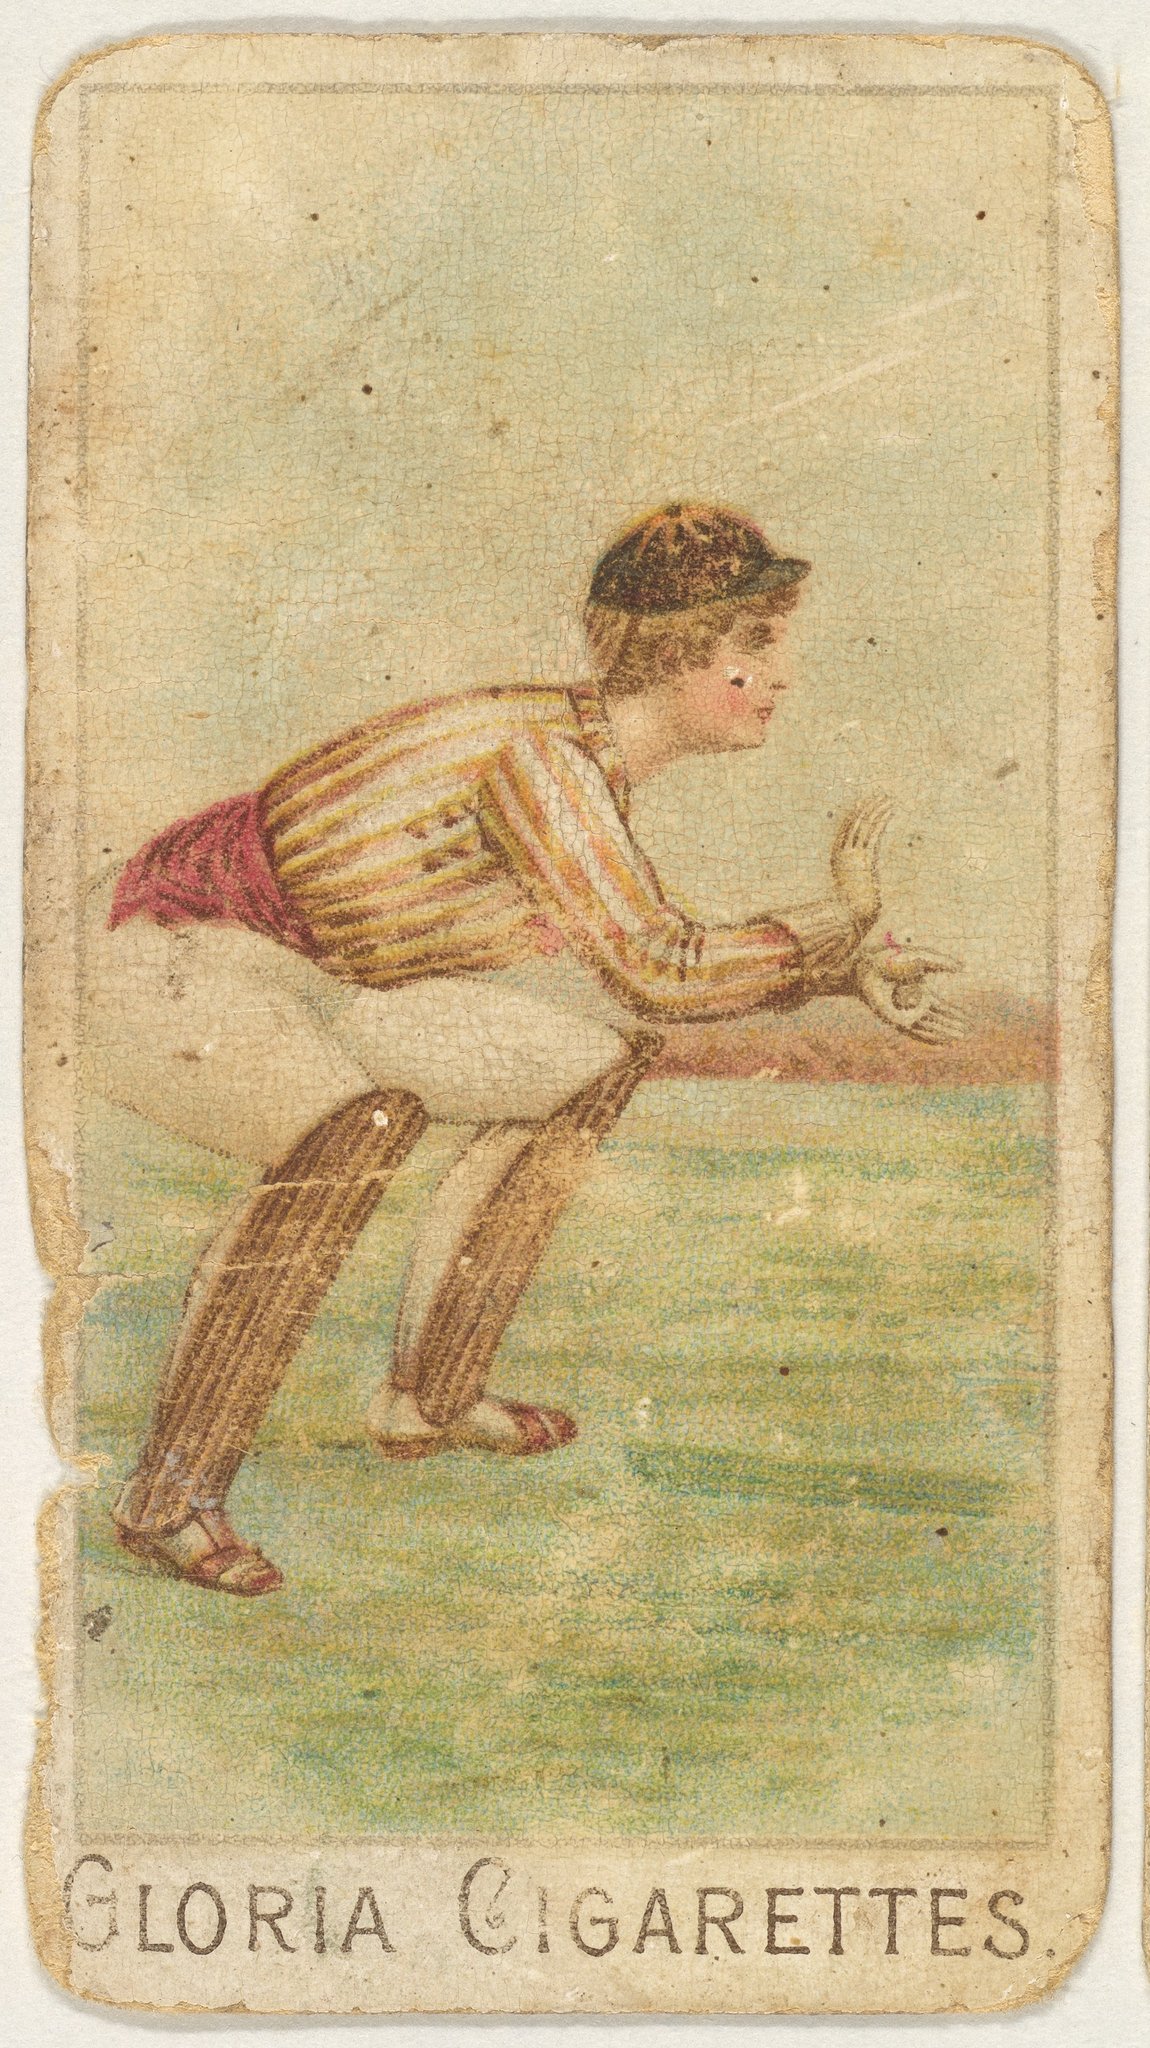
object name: print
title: From the series "Sports Girls" (C190), issued by the American Cigarette Company, Ltd., Montreal, to promote Gloria Cigarettes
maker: american cigarette company, ltd.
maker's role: publisher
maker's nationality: canadian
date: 1889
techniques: color lithograph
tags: girls,sports,athletes